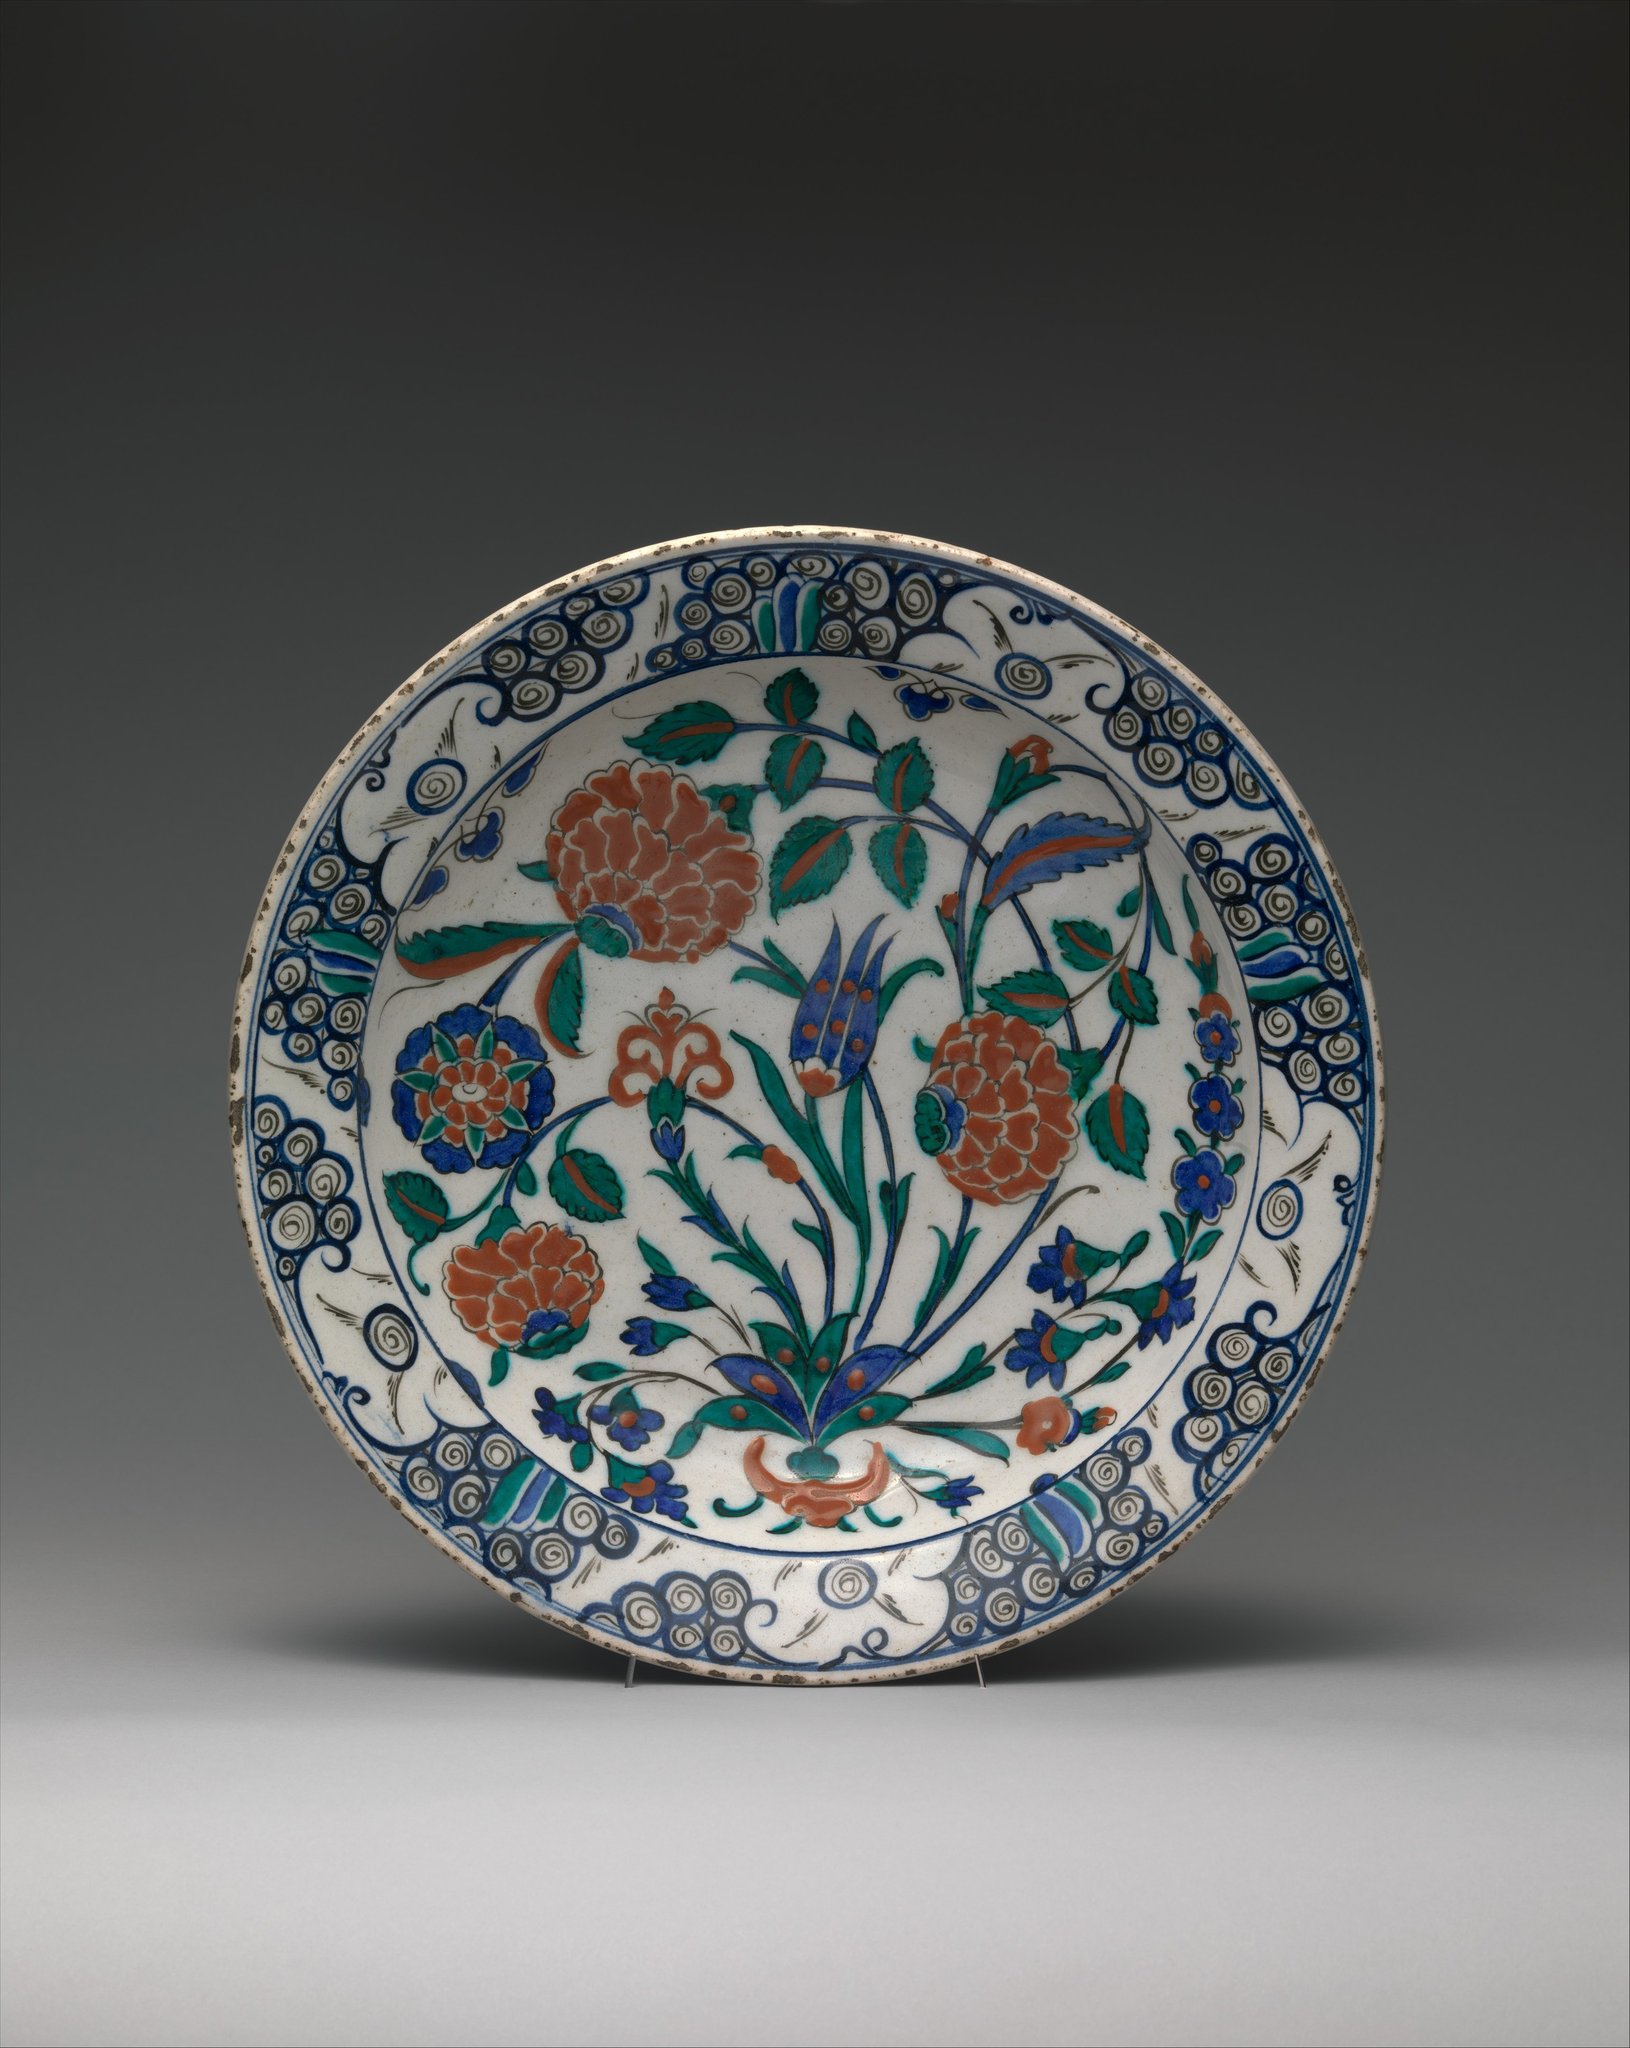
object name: dish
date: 1501-1600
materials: glaze, stonepaste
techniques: painting, polychrome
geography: turkey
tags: flowers,leaves